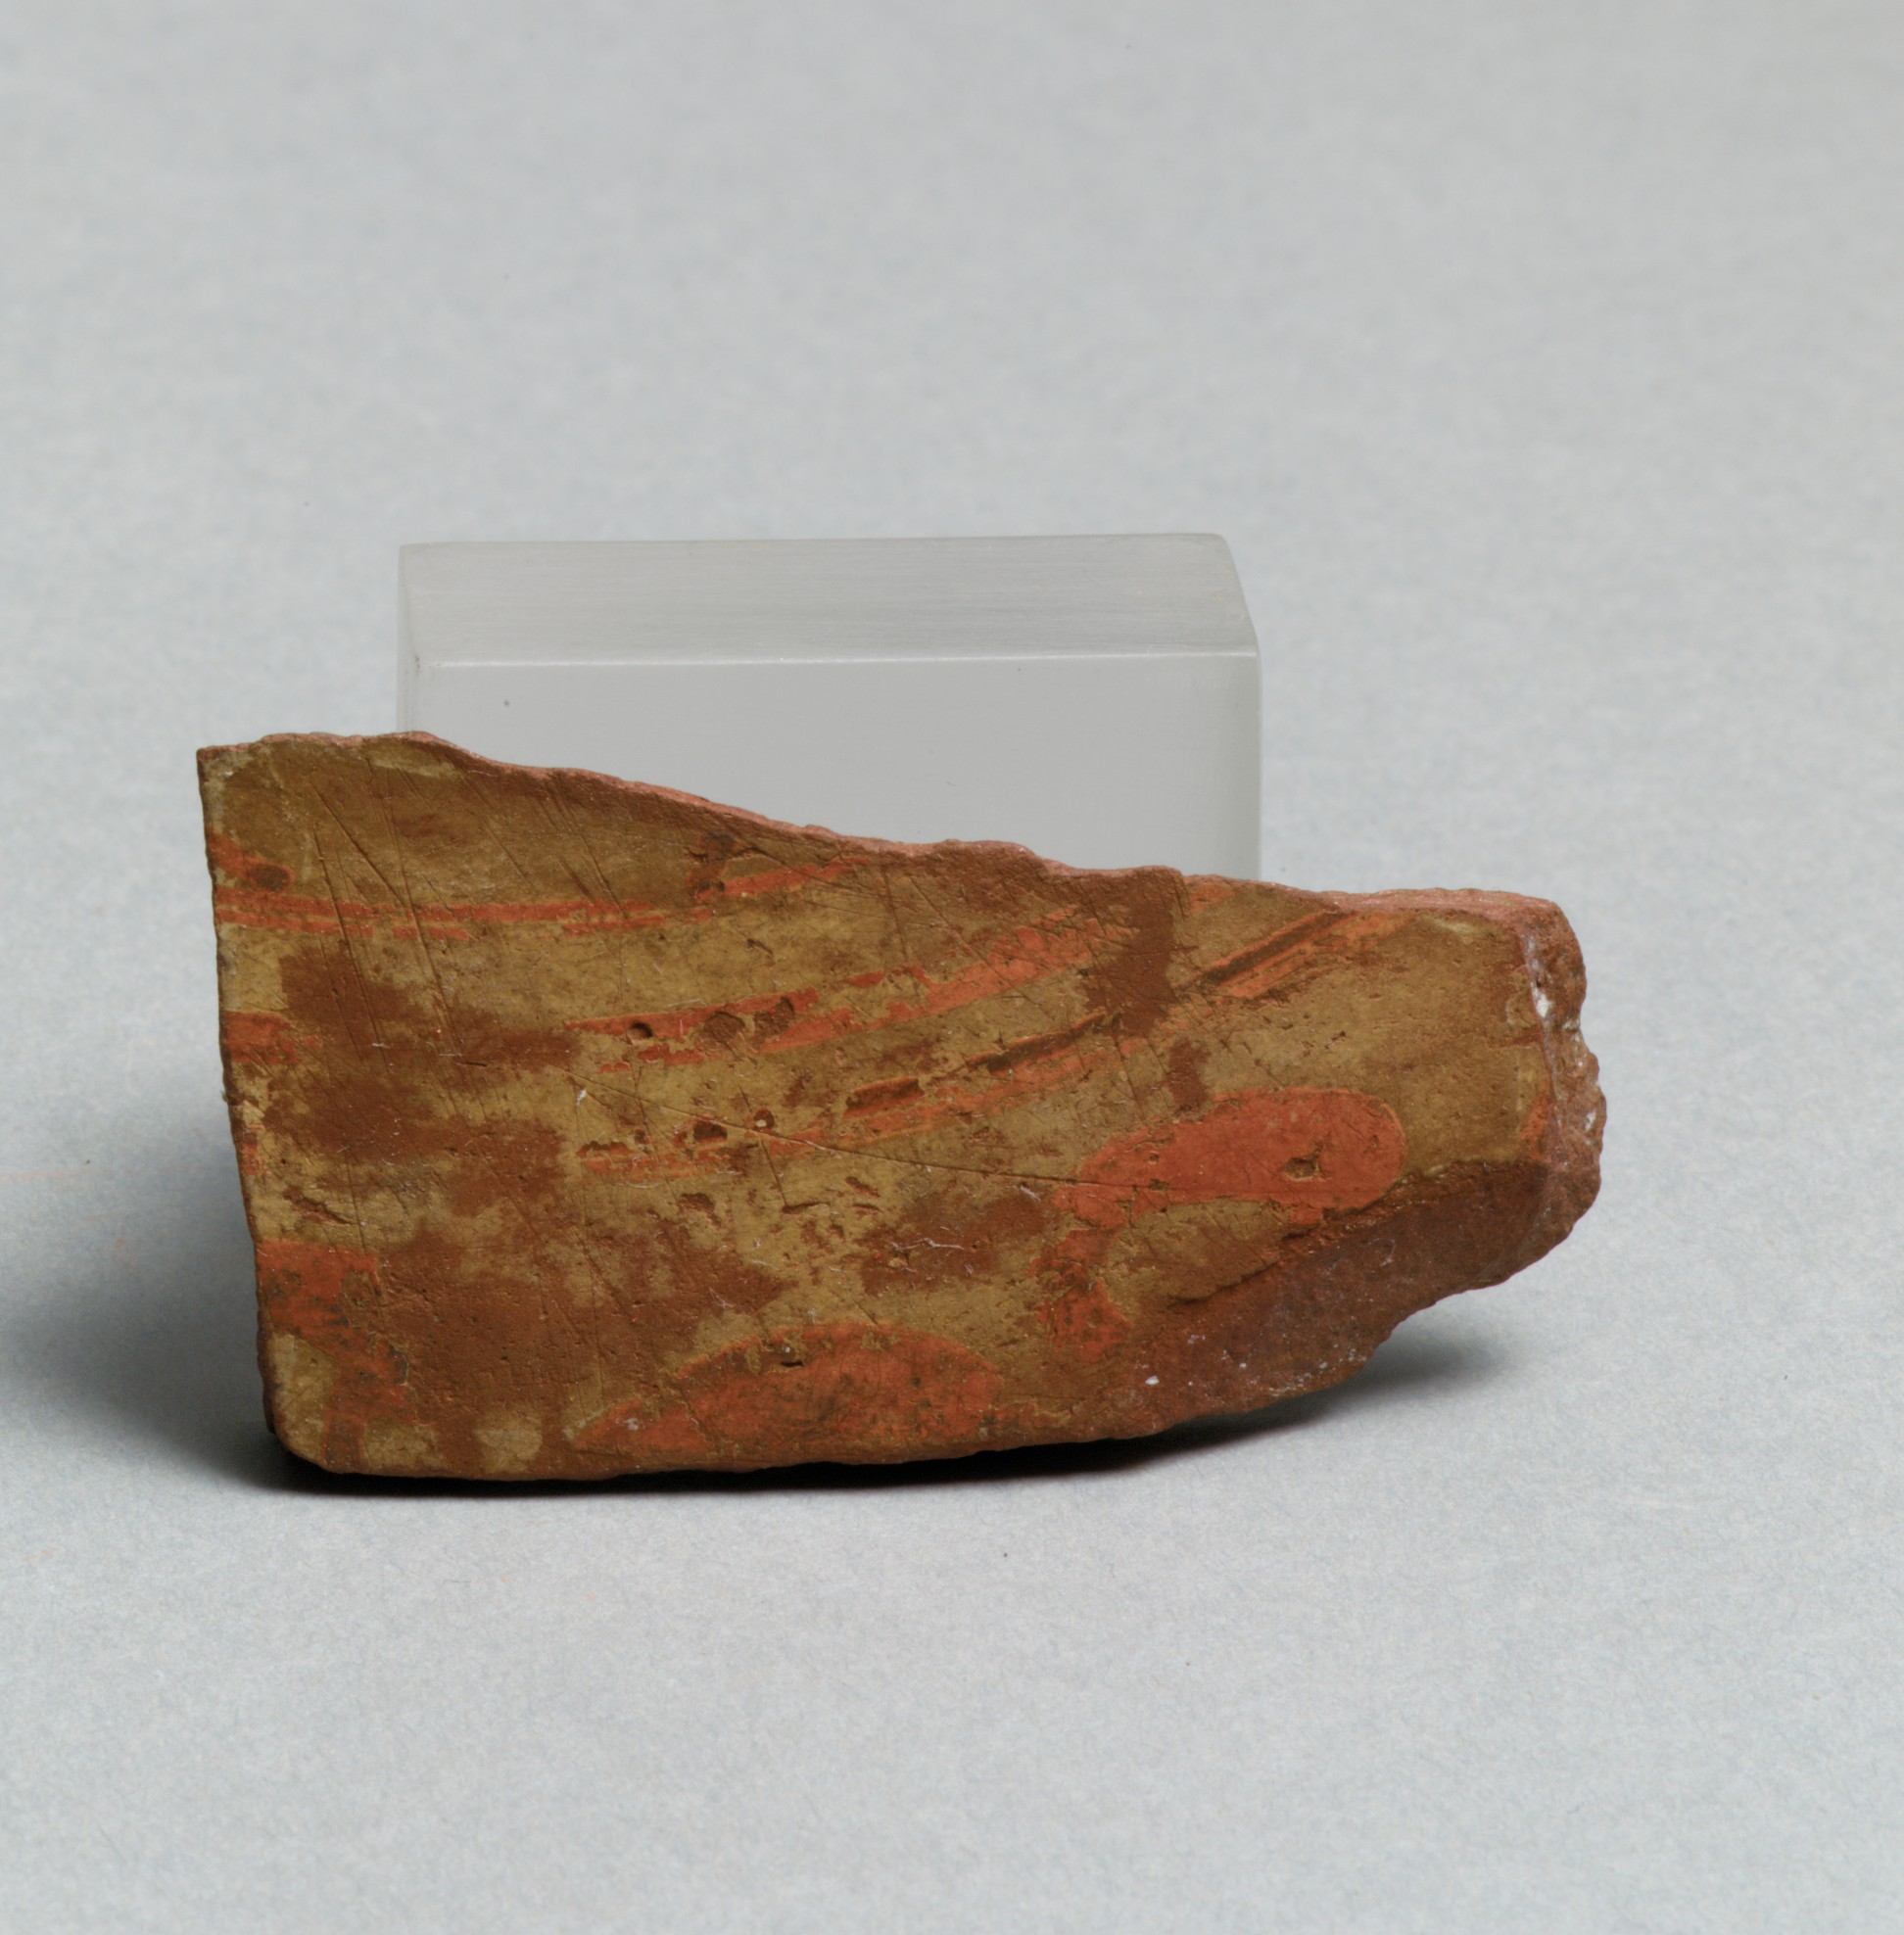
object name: vase fragment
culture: greek or lydian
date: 900-30 BCE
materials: terracotta